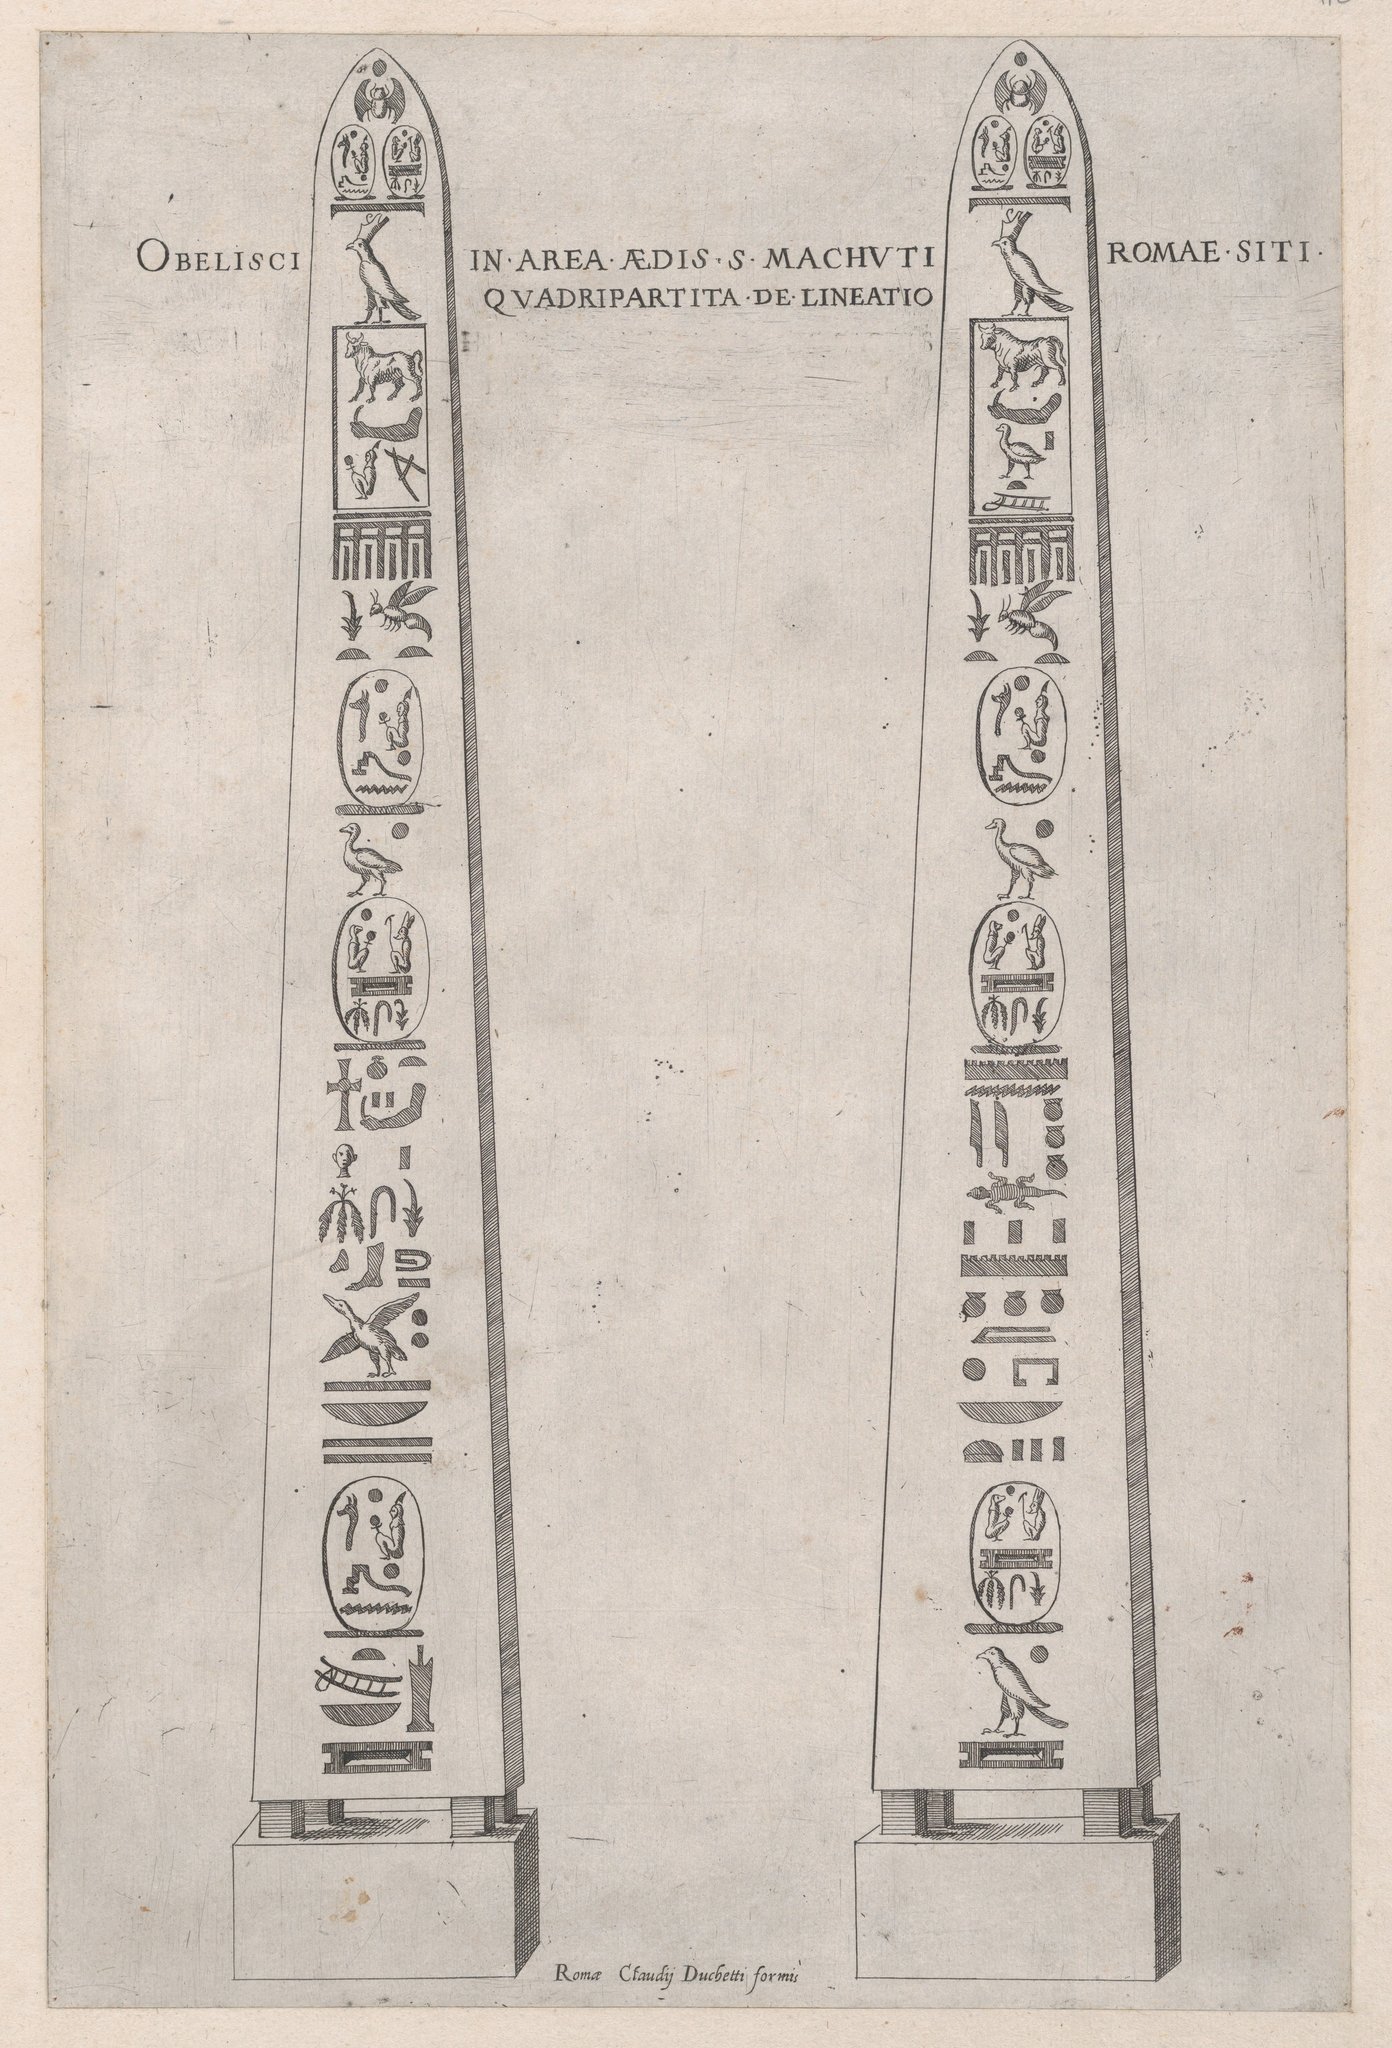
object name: print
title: Egyptian Obelisk, from "Speculum Romanae Magnificentiae"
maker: etienne dupérac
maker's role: artist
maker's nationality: french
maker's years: 1535-1604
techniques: engraving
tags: obelisks,hieroglyphs,rome